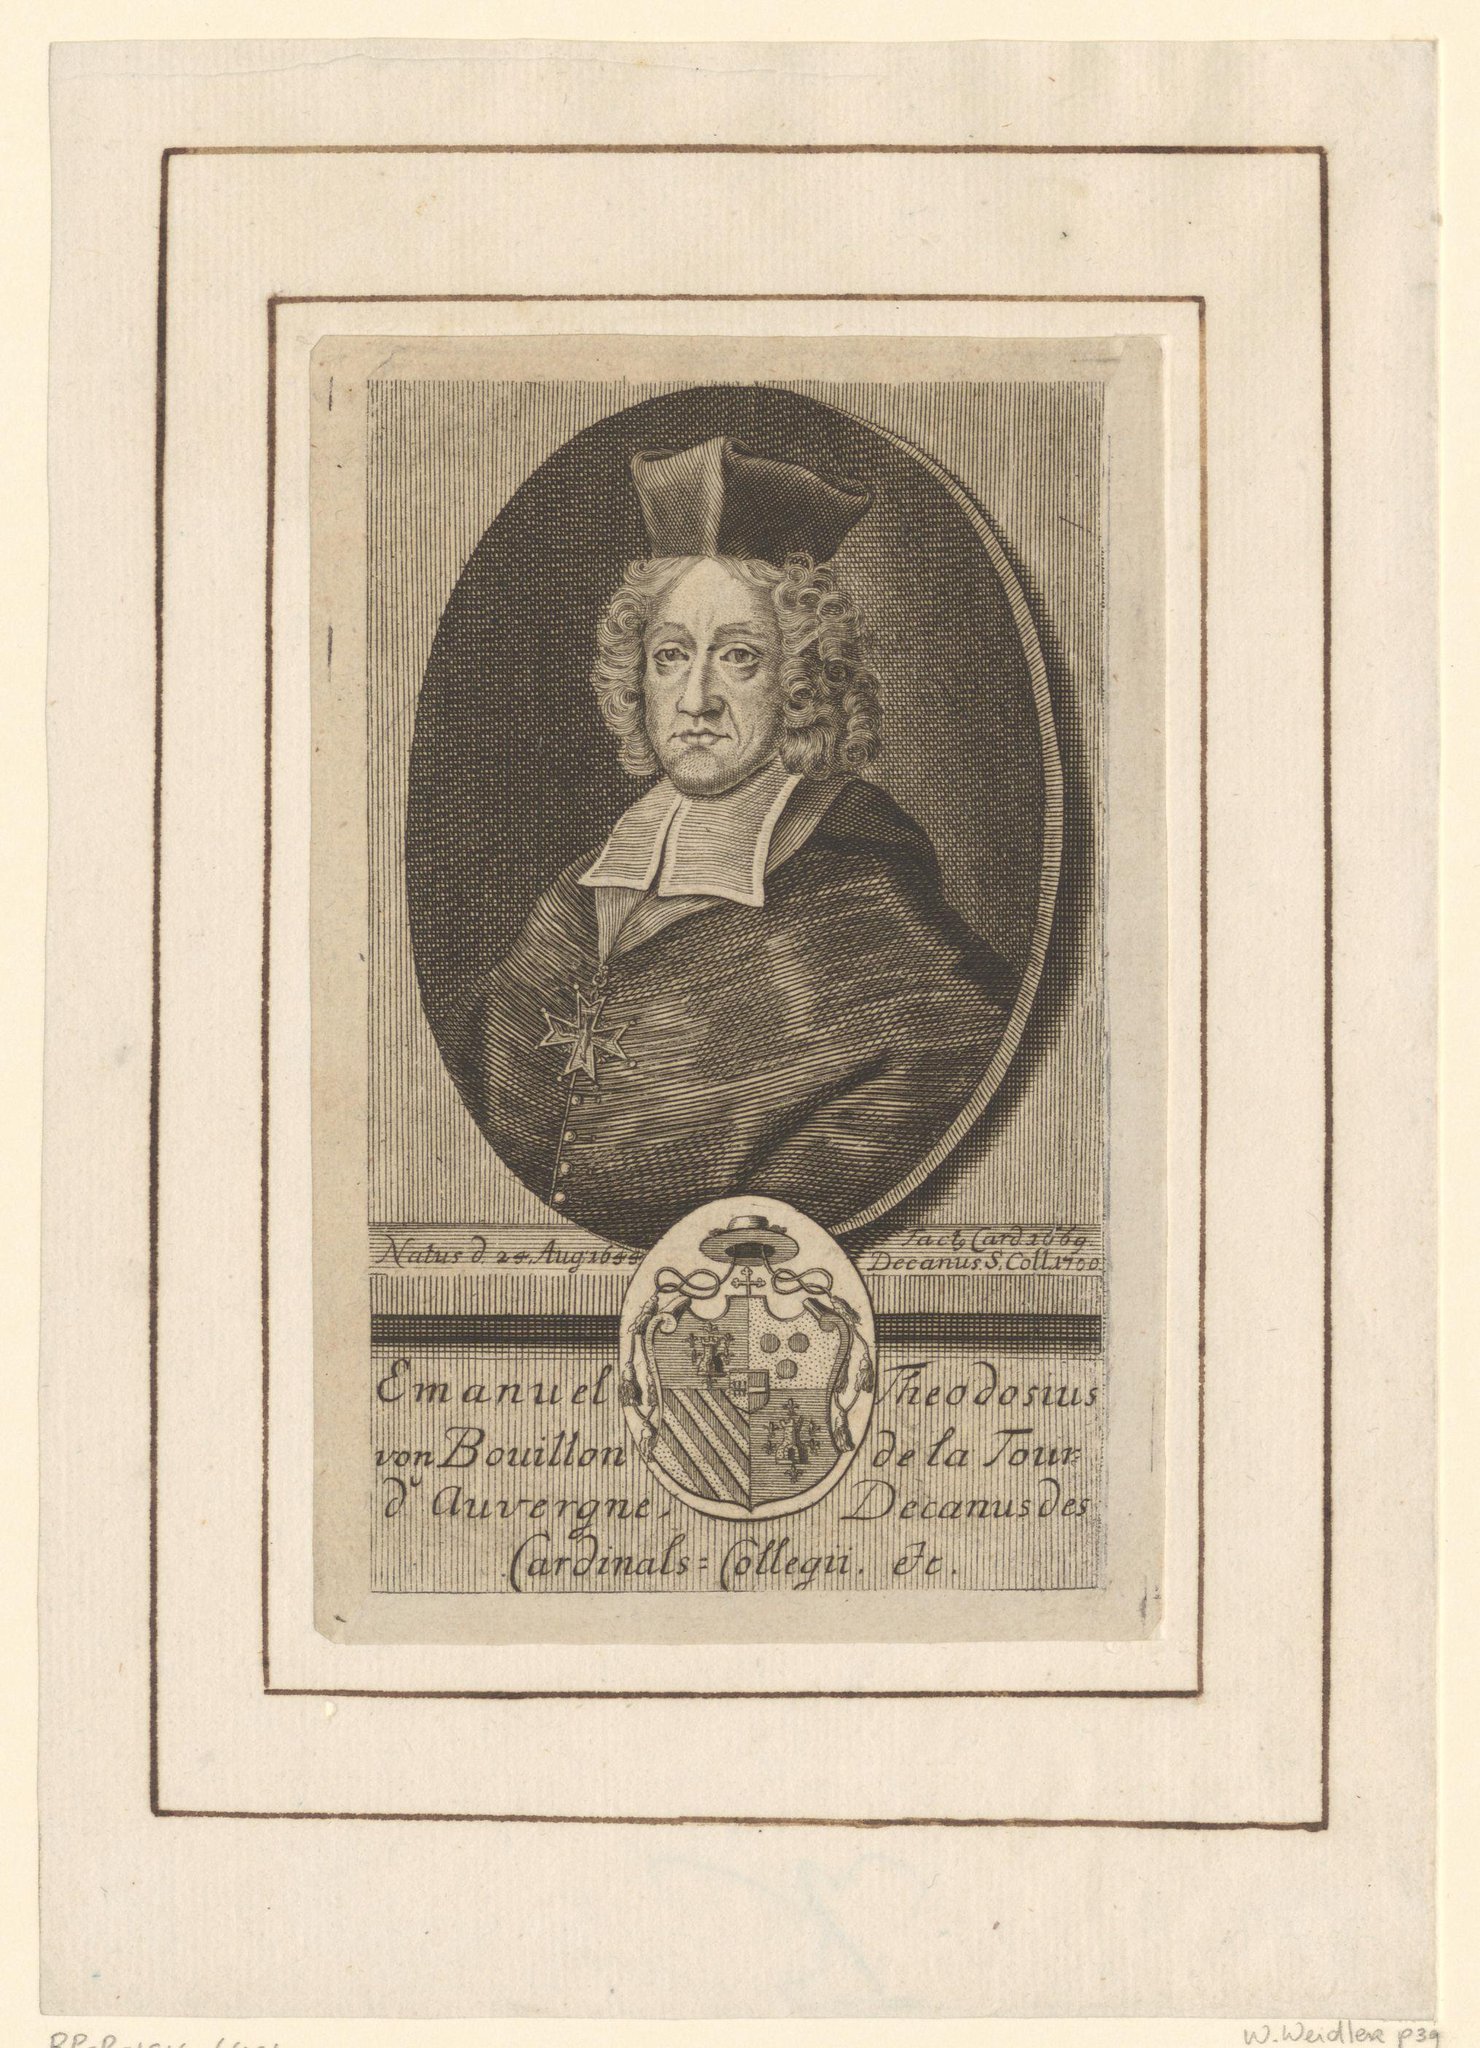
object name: print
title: Portret van Emmanuel Théodose de la Tour d'Auvergne, kardinaal van Bouillon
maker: martin bernigeroth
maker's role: print maker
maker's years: 1670-1733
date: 1714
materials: paper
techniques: engraving, etching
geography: leipzig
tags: historical persons, armorial bearing, heraldry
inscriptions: collector's mark: Lugt 2228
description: Prent ook gebruikt in: Curieuses Bücher- und Staats-Cabinett (...) XXV. Eingang, 1714.